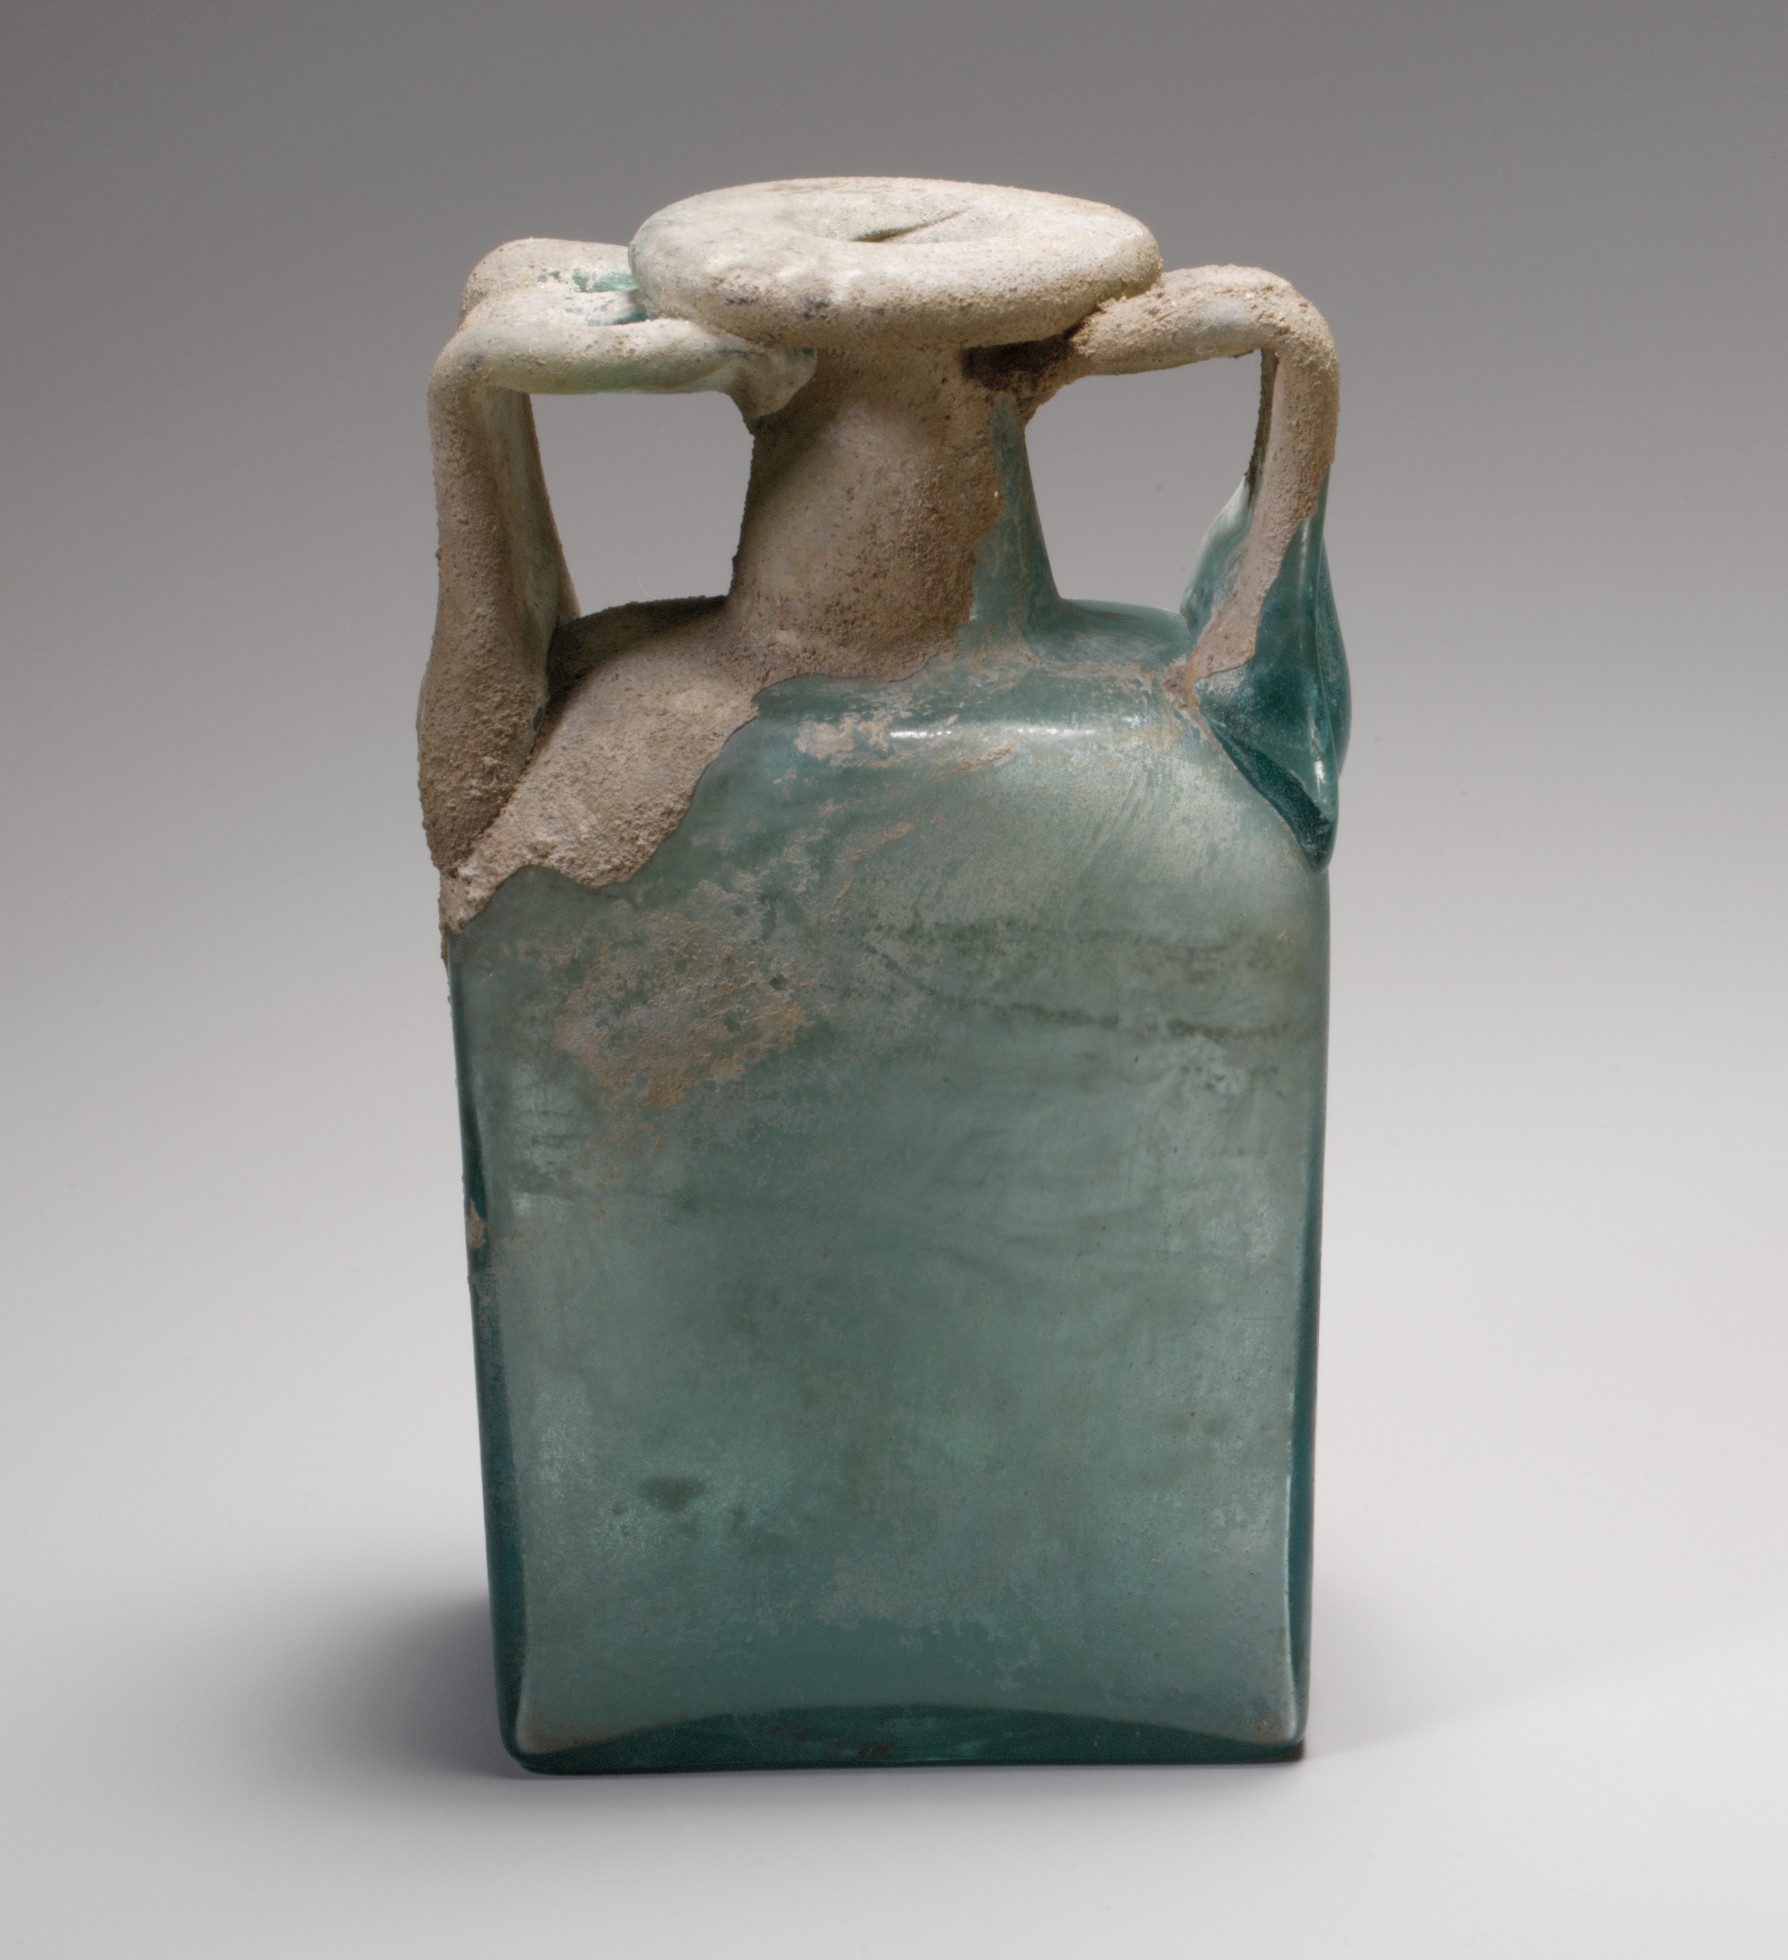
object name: bottle, rectangular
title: Glass rectangular bottle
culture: roman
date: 101-300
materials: glass